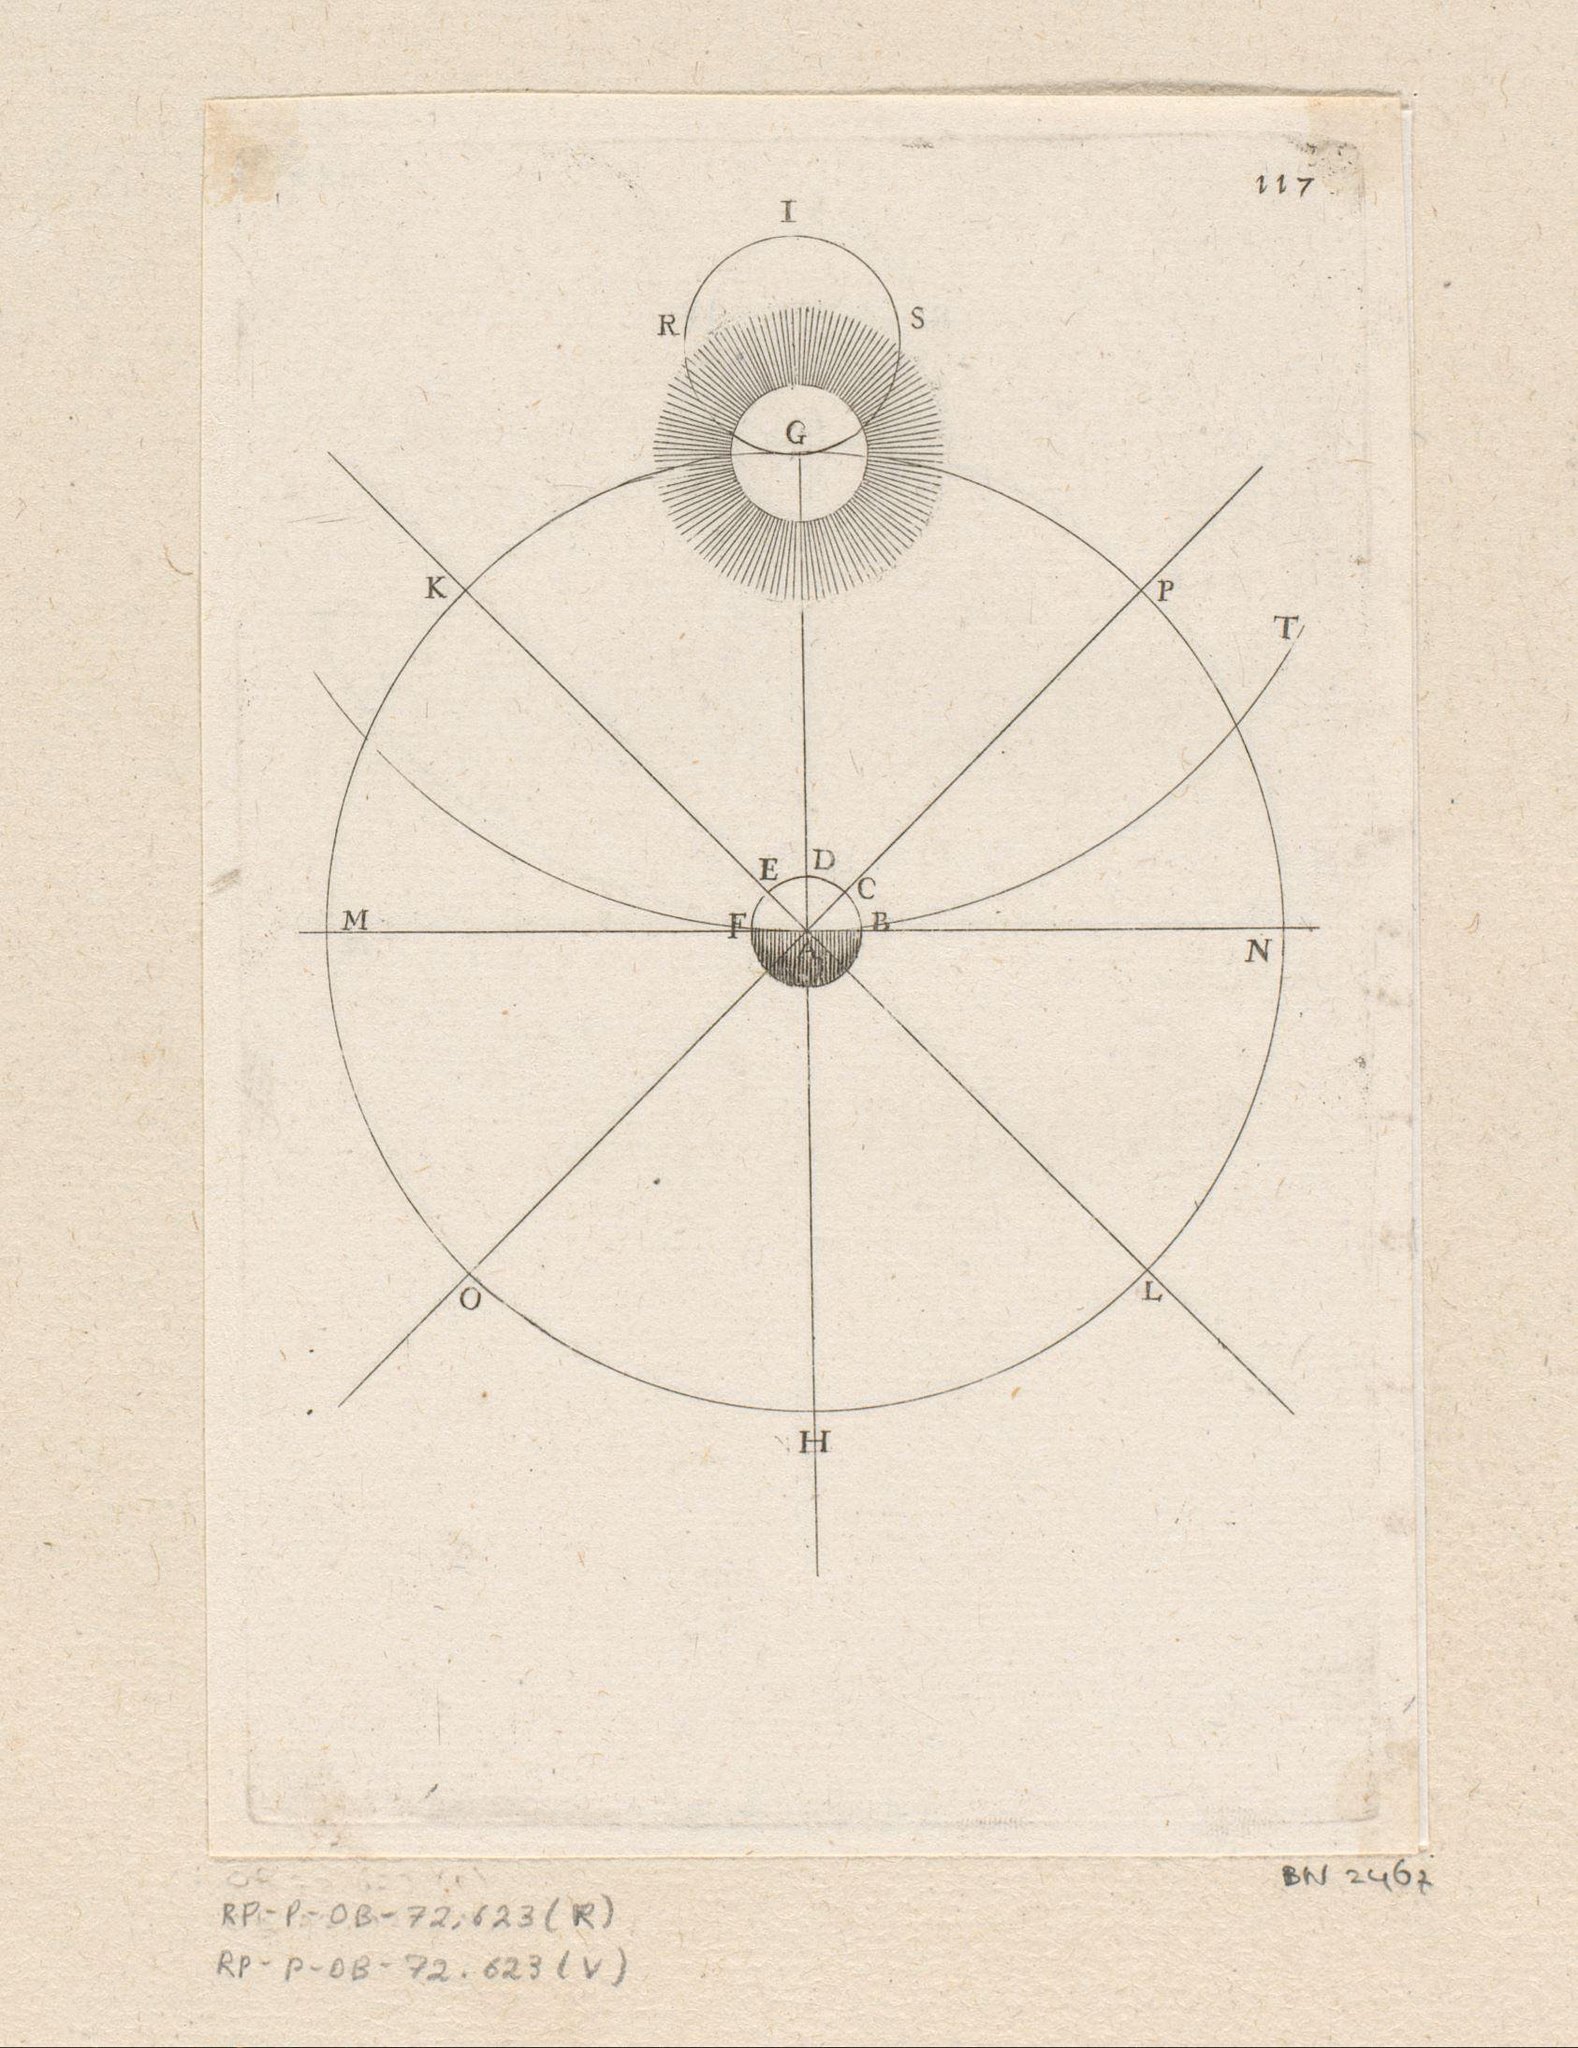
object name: book illustration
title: Beweging van de Zon ten opzichte van de Aarde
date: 1706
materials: paper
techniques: etching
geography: paris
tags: earth, world as celestial body, sun as celestial body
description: Prent uit: Leclerc, Sébastien. Nouveau systeme du monde conforme à l'Ecriture sainte. Où les phénomènes sont expliquez sans excentricité de mouvement (...). Paris: Pierre Giffart, 1706.